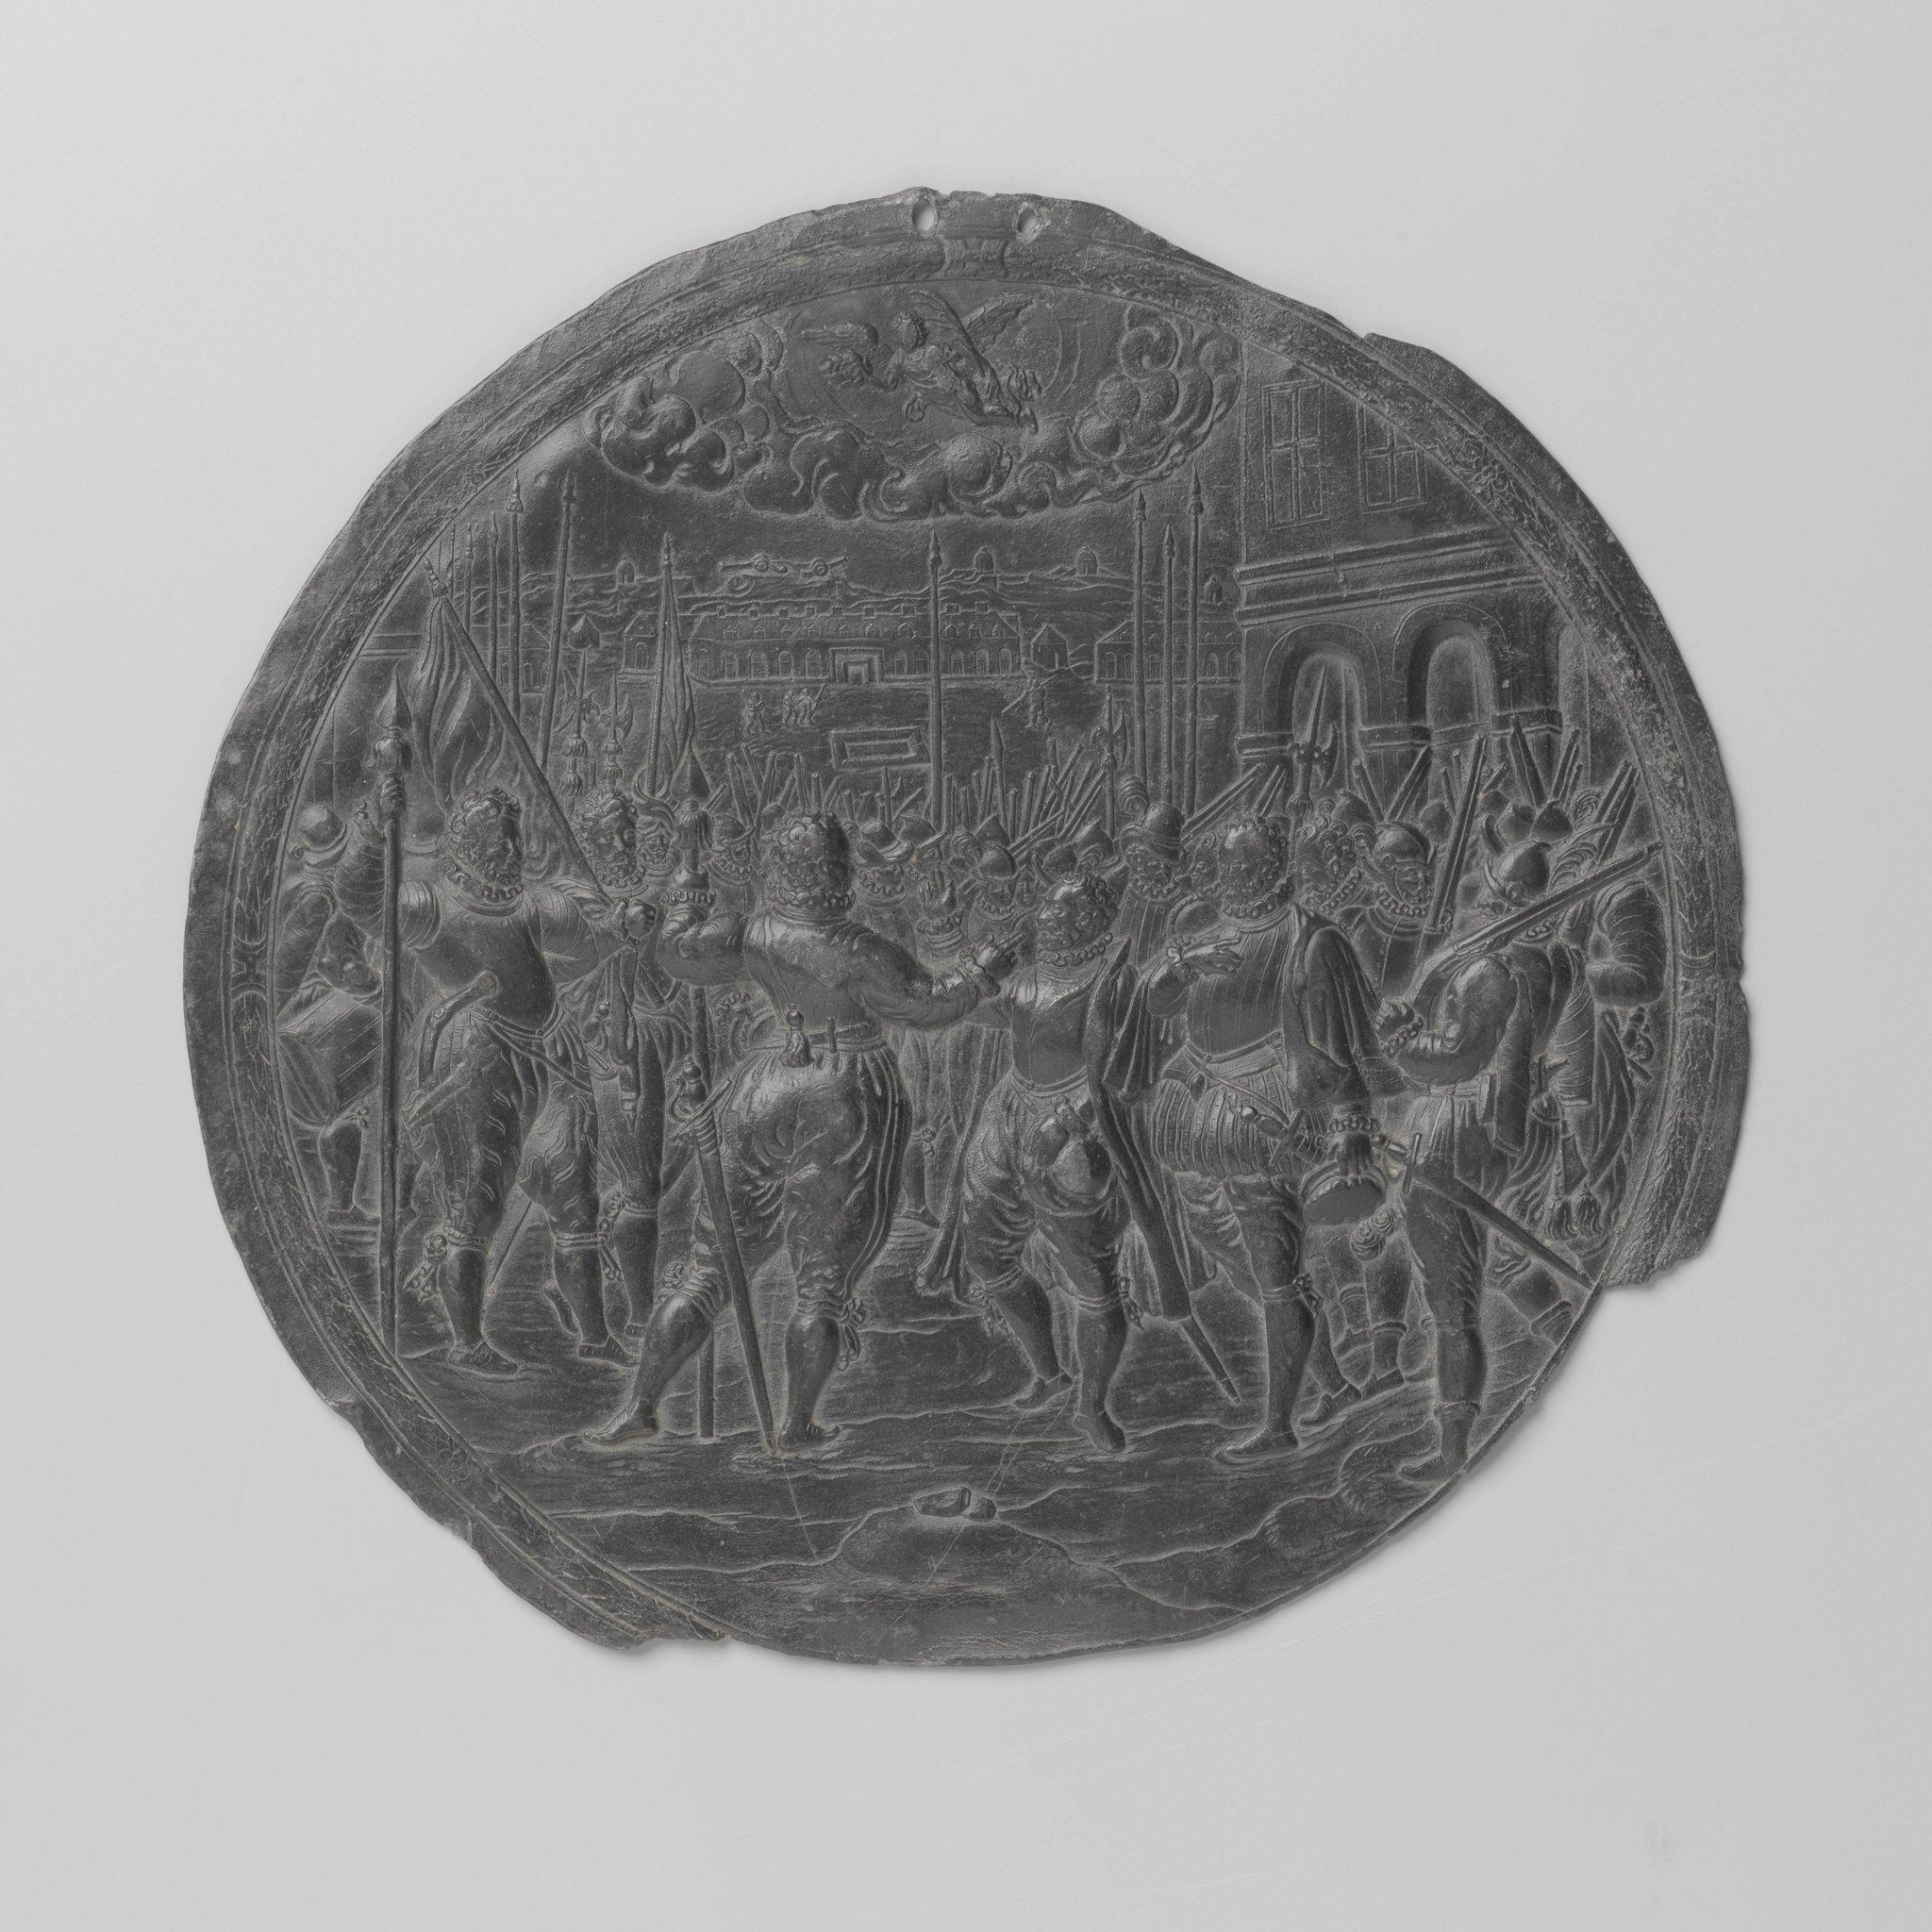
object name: plaque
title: De inneming van het kasteel van Antwerpen in het jaar 1577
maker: Anonymous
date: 1577-1600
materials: lead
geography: southern netherlands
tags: fernando álvarez de toledo (3rd duke of alba), antwerp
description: Een ronde plaquette van lood met een voorstelling van de eed van trouw aan de staten, bij de inneming van het kasteel van Antwerpen.